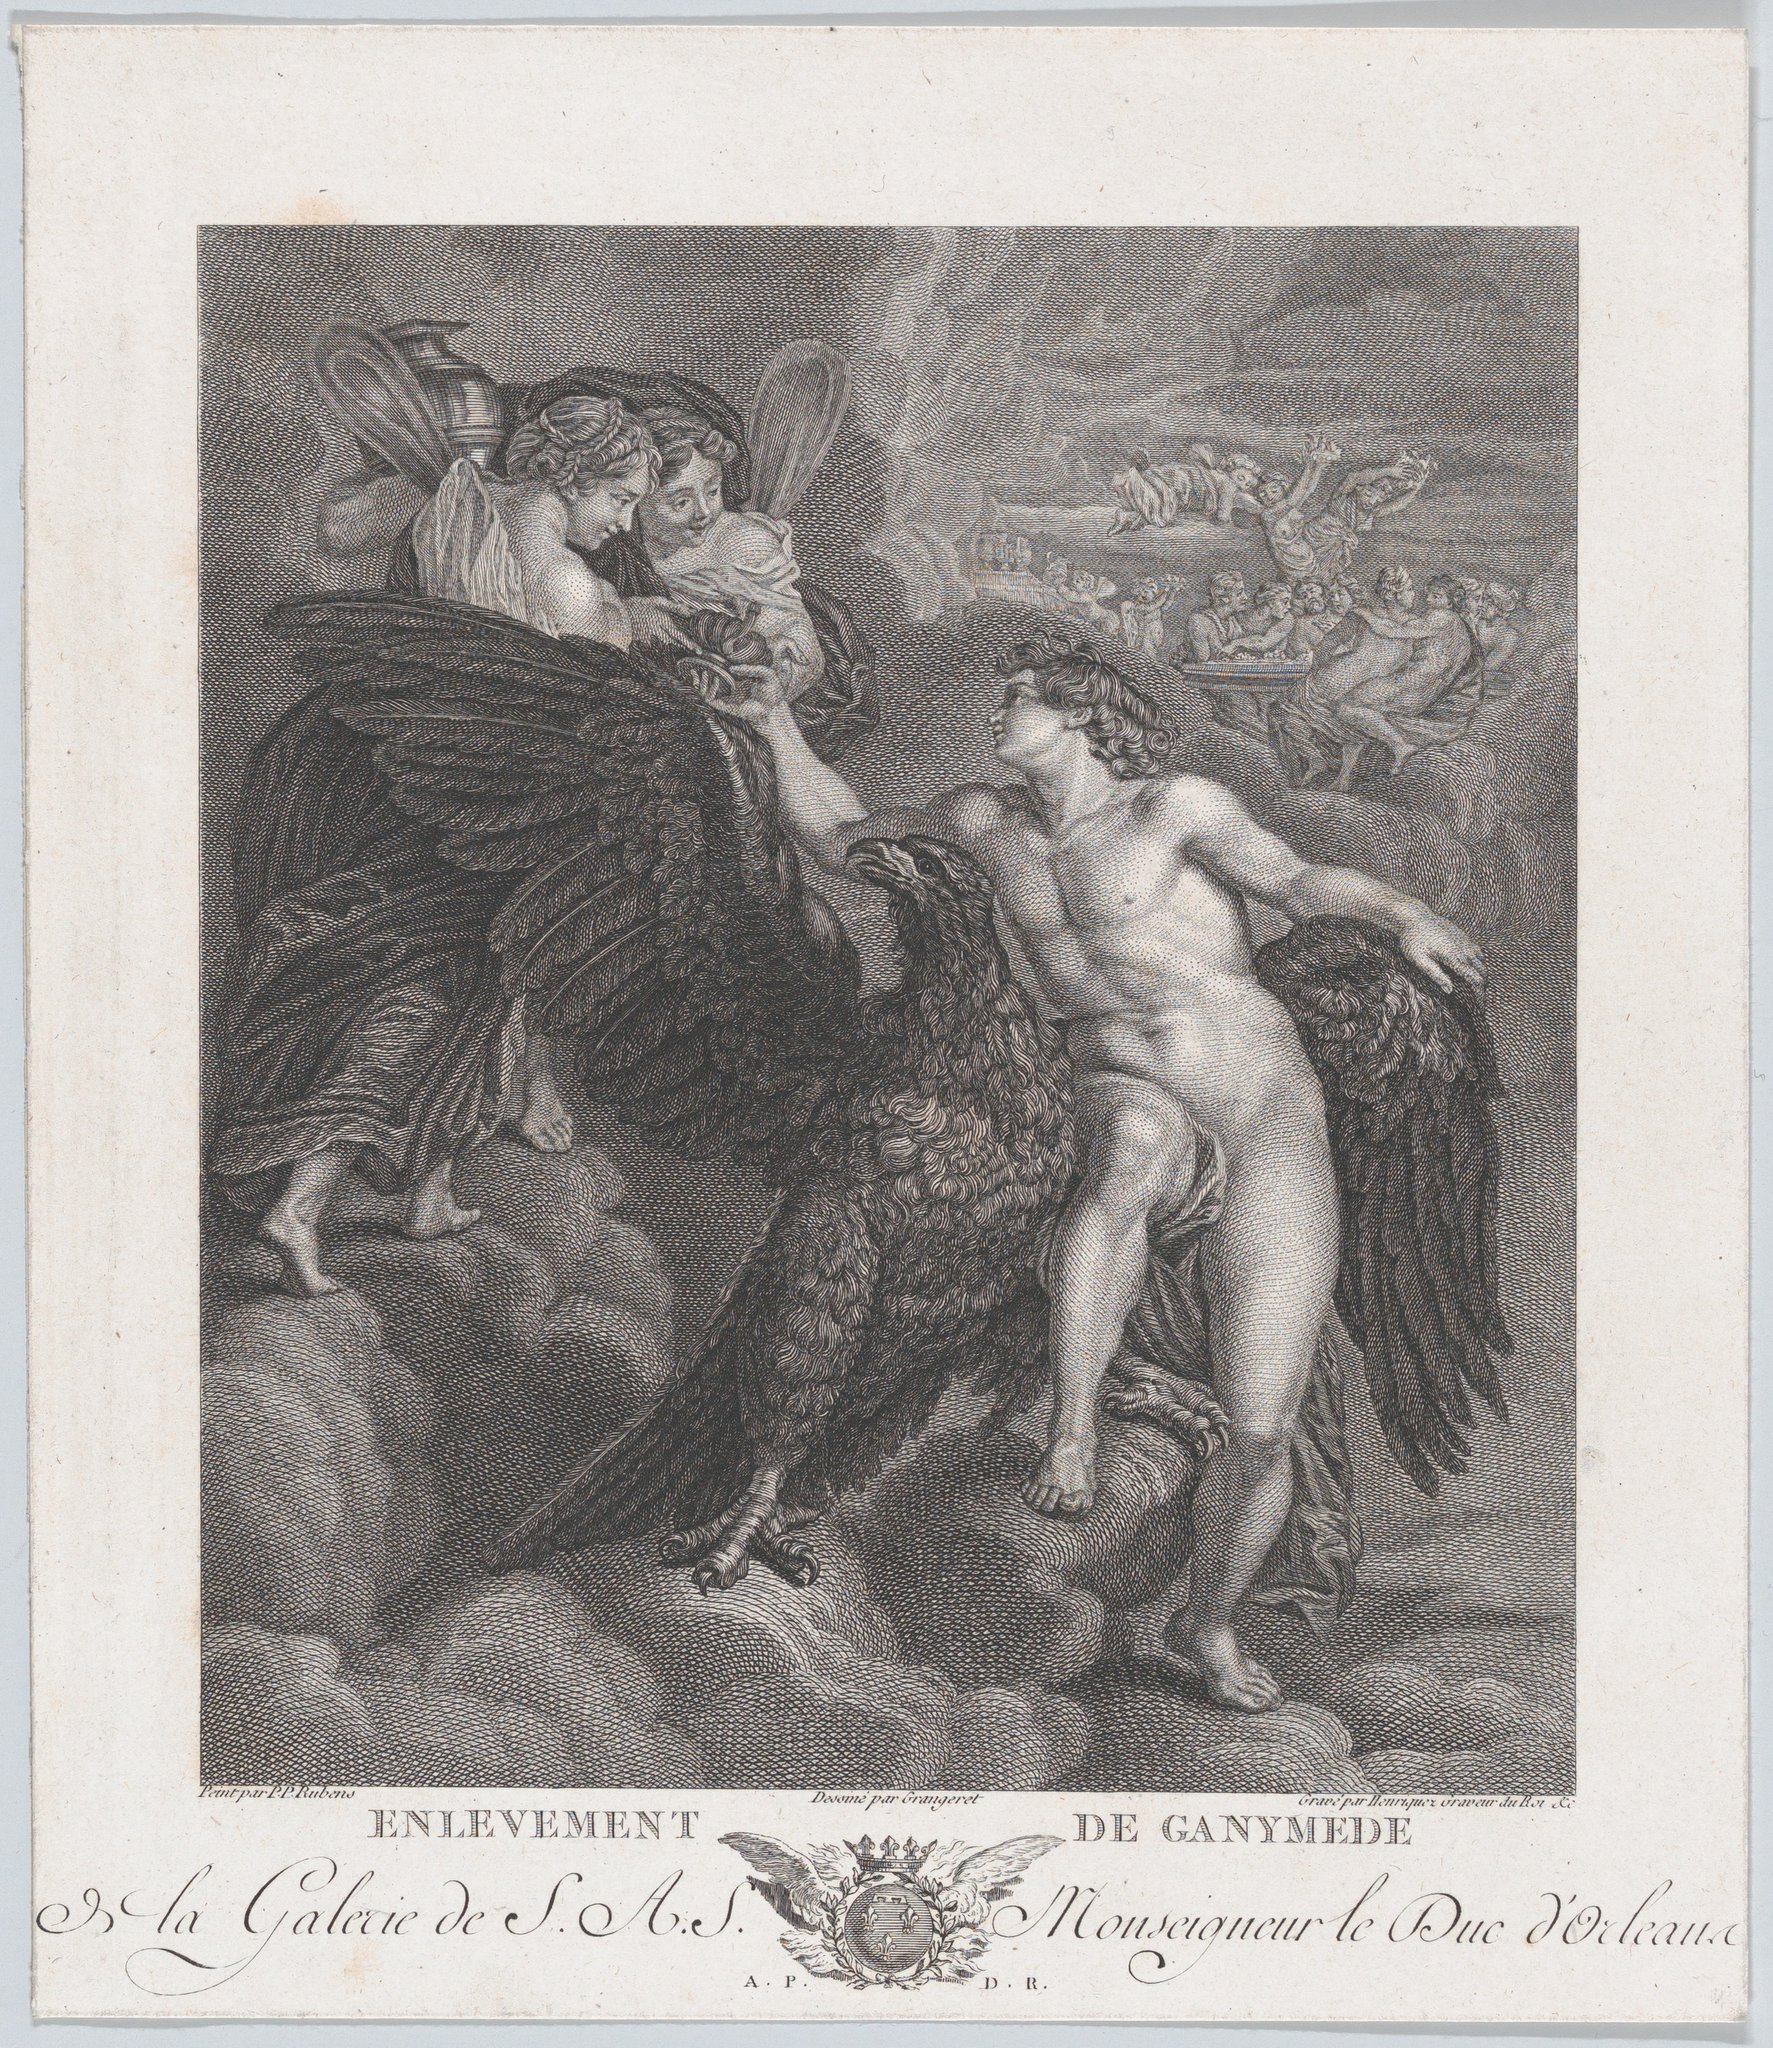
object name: print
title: Ganymede, leaning on an eagle, receiving the cup from Hebe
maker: benoît louis henriquez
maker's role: artist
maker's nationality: french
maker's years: 1732-1806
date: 1786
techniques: engraving